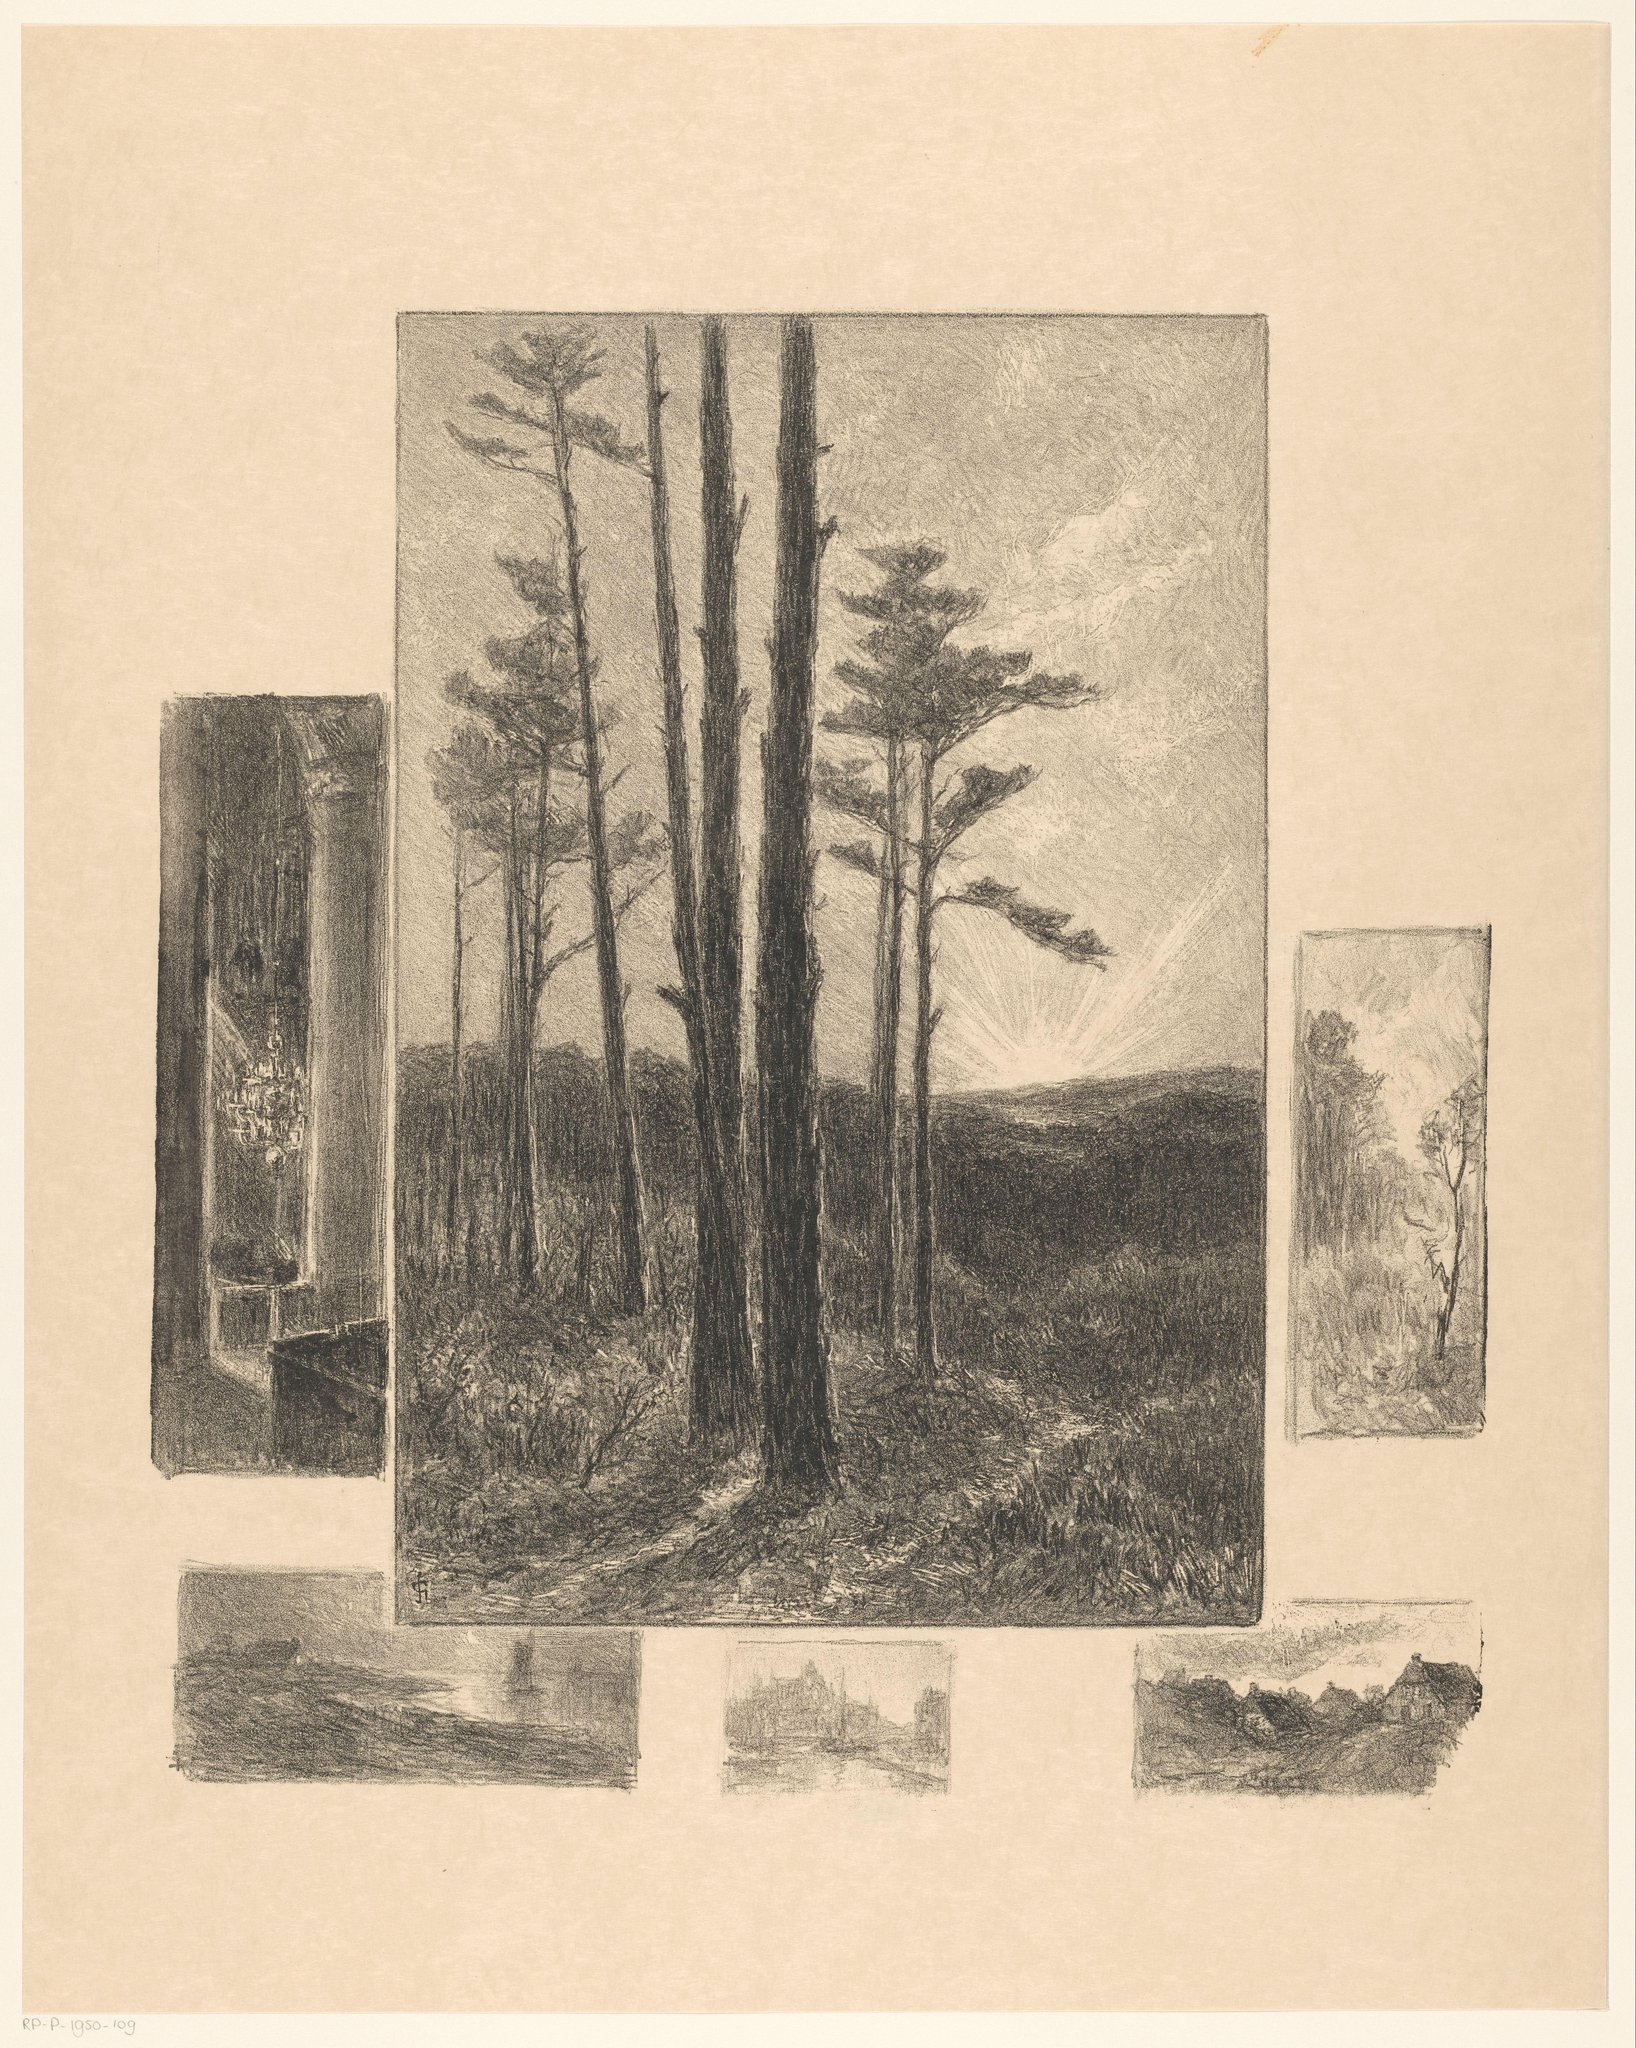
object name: print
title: Reichswald te Kleef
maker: carel nicolaas storm van s-gravesande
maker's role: draughtsman, print maker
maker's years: 1841-1924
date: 1851-1924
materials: paper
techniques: lithograph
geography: netherlands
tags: forest, wood, sunset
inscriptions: collector's mark: Lugt 2228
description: Een ondergaande zon in het Reichswald bij Kleef. Rondom vijf gezichten op een interieur, een landschap en steden.